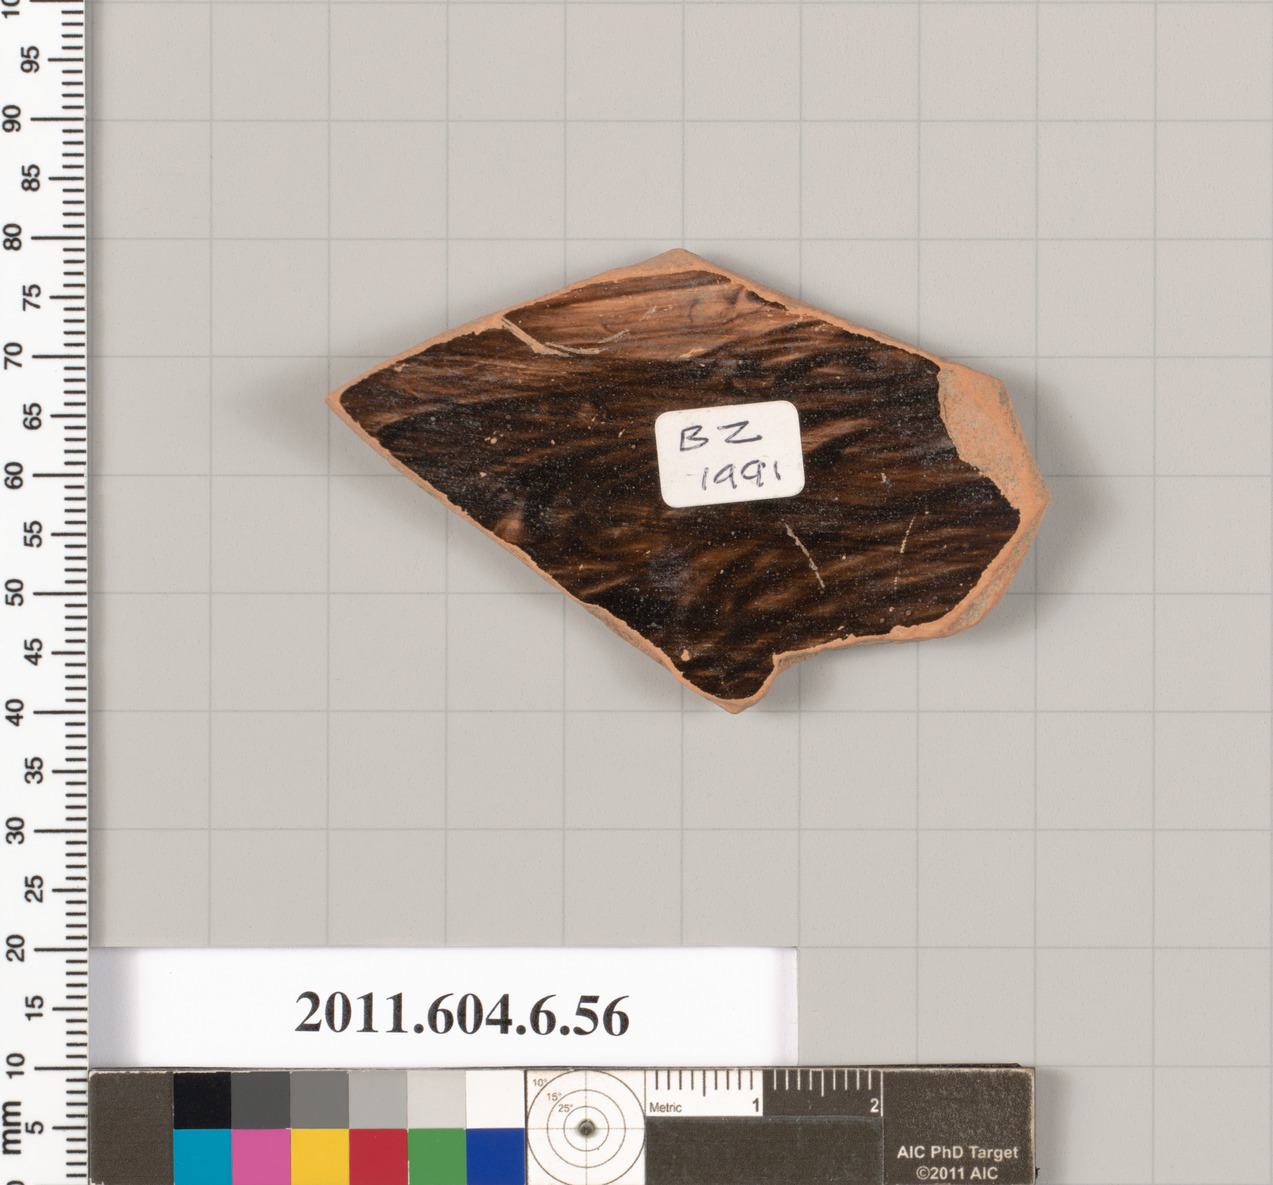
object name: undetermined shape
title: Terracotta fragment of an undetermined shape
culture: greek, attic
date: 600-401 BCE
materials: terracotta